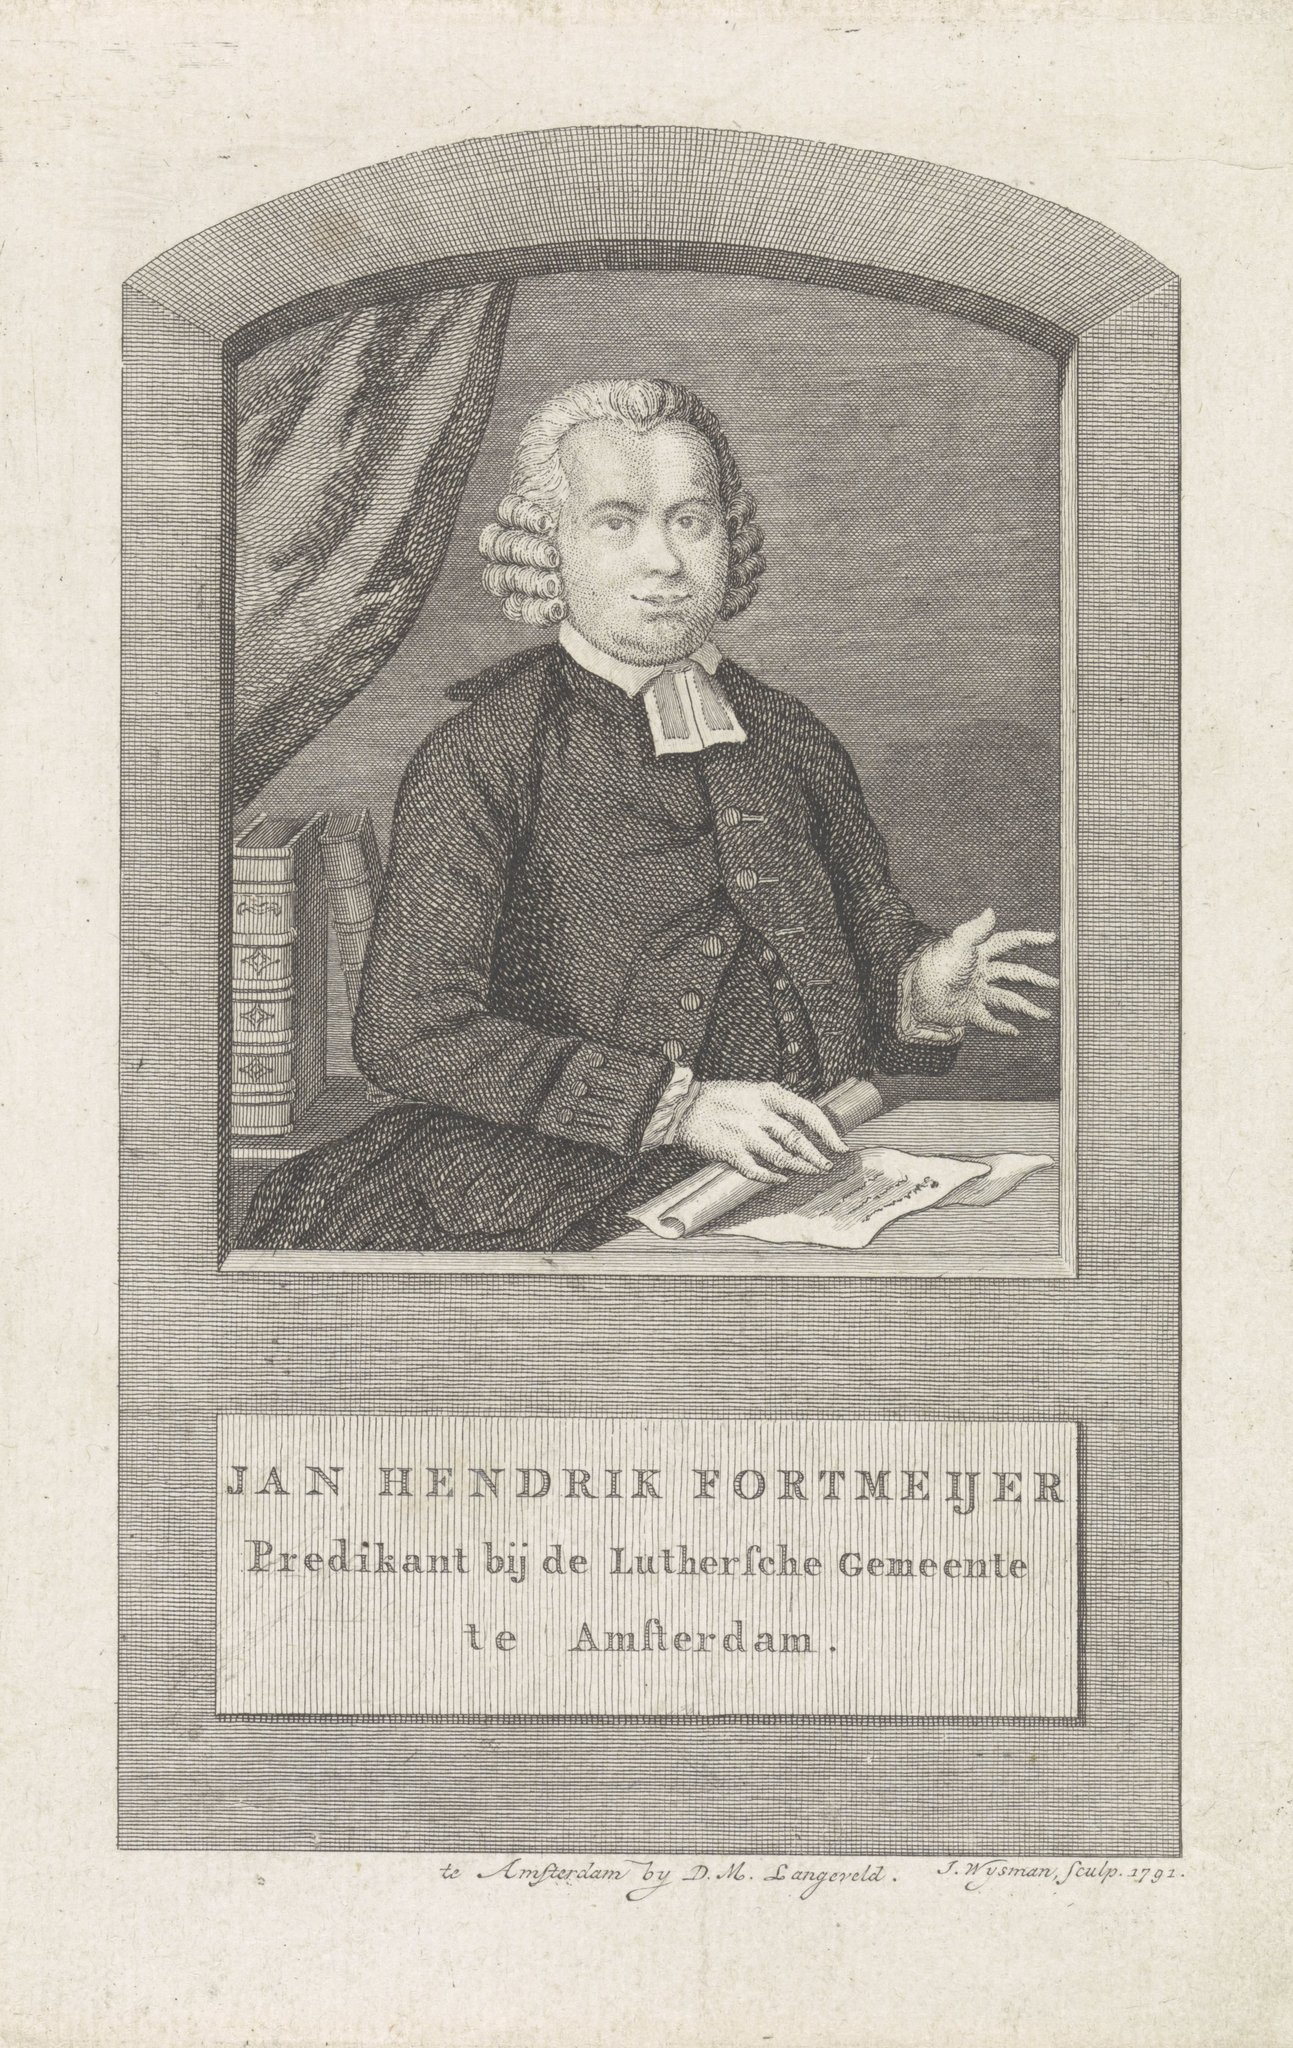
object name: print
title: Portret van Jan Hendrik Fortmeijer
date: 1791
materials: paper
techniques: engraving, etching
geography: amsterdam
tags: leiden, amsterdam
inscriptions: collector's mark: Lugt 2228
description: Portret van Jan Hendrik Fortmeijer, luthers predikant te Amsterdam.